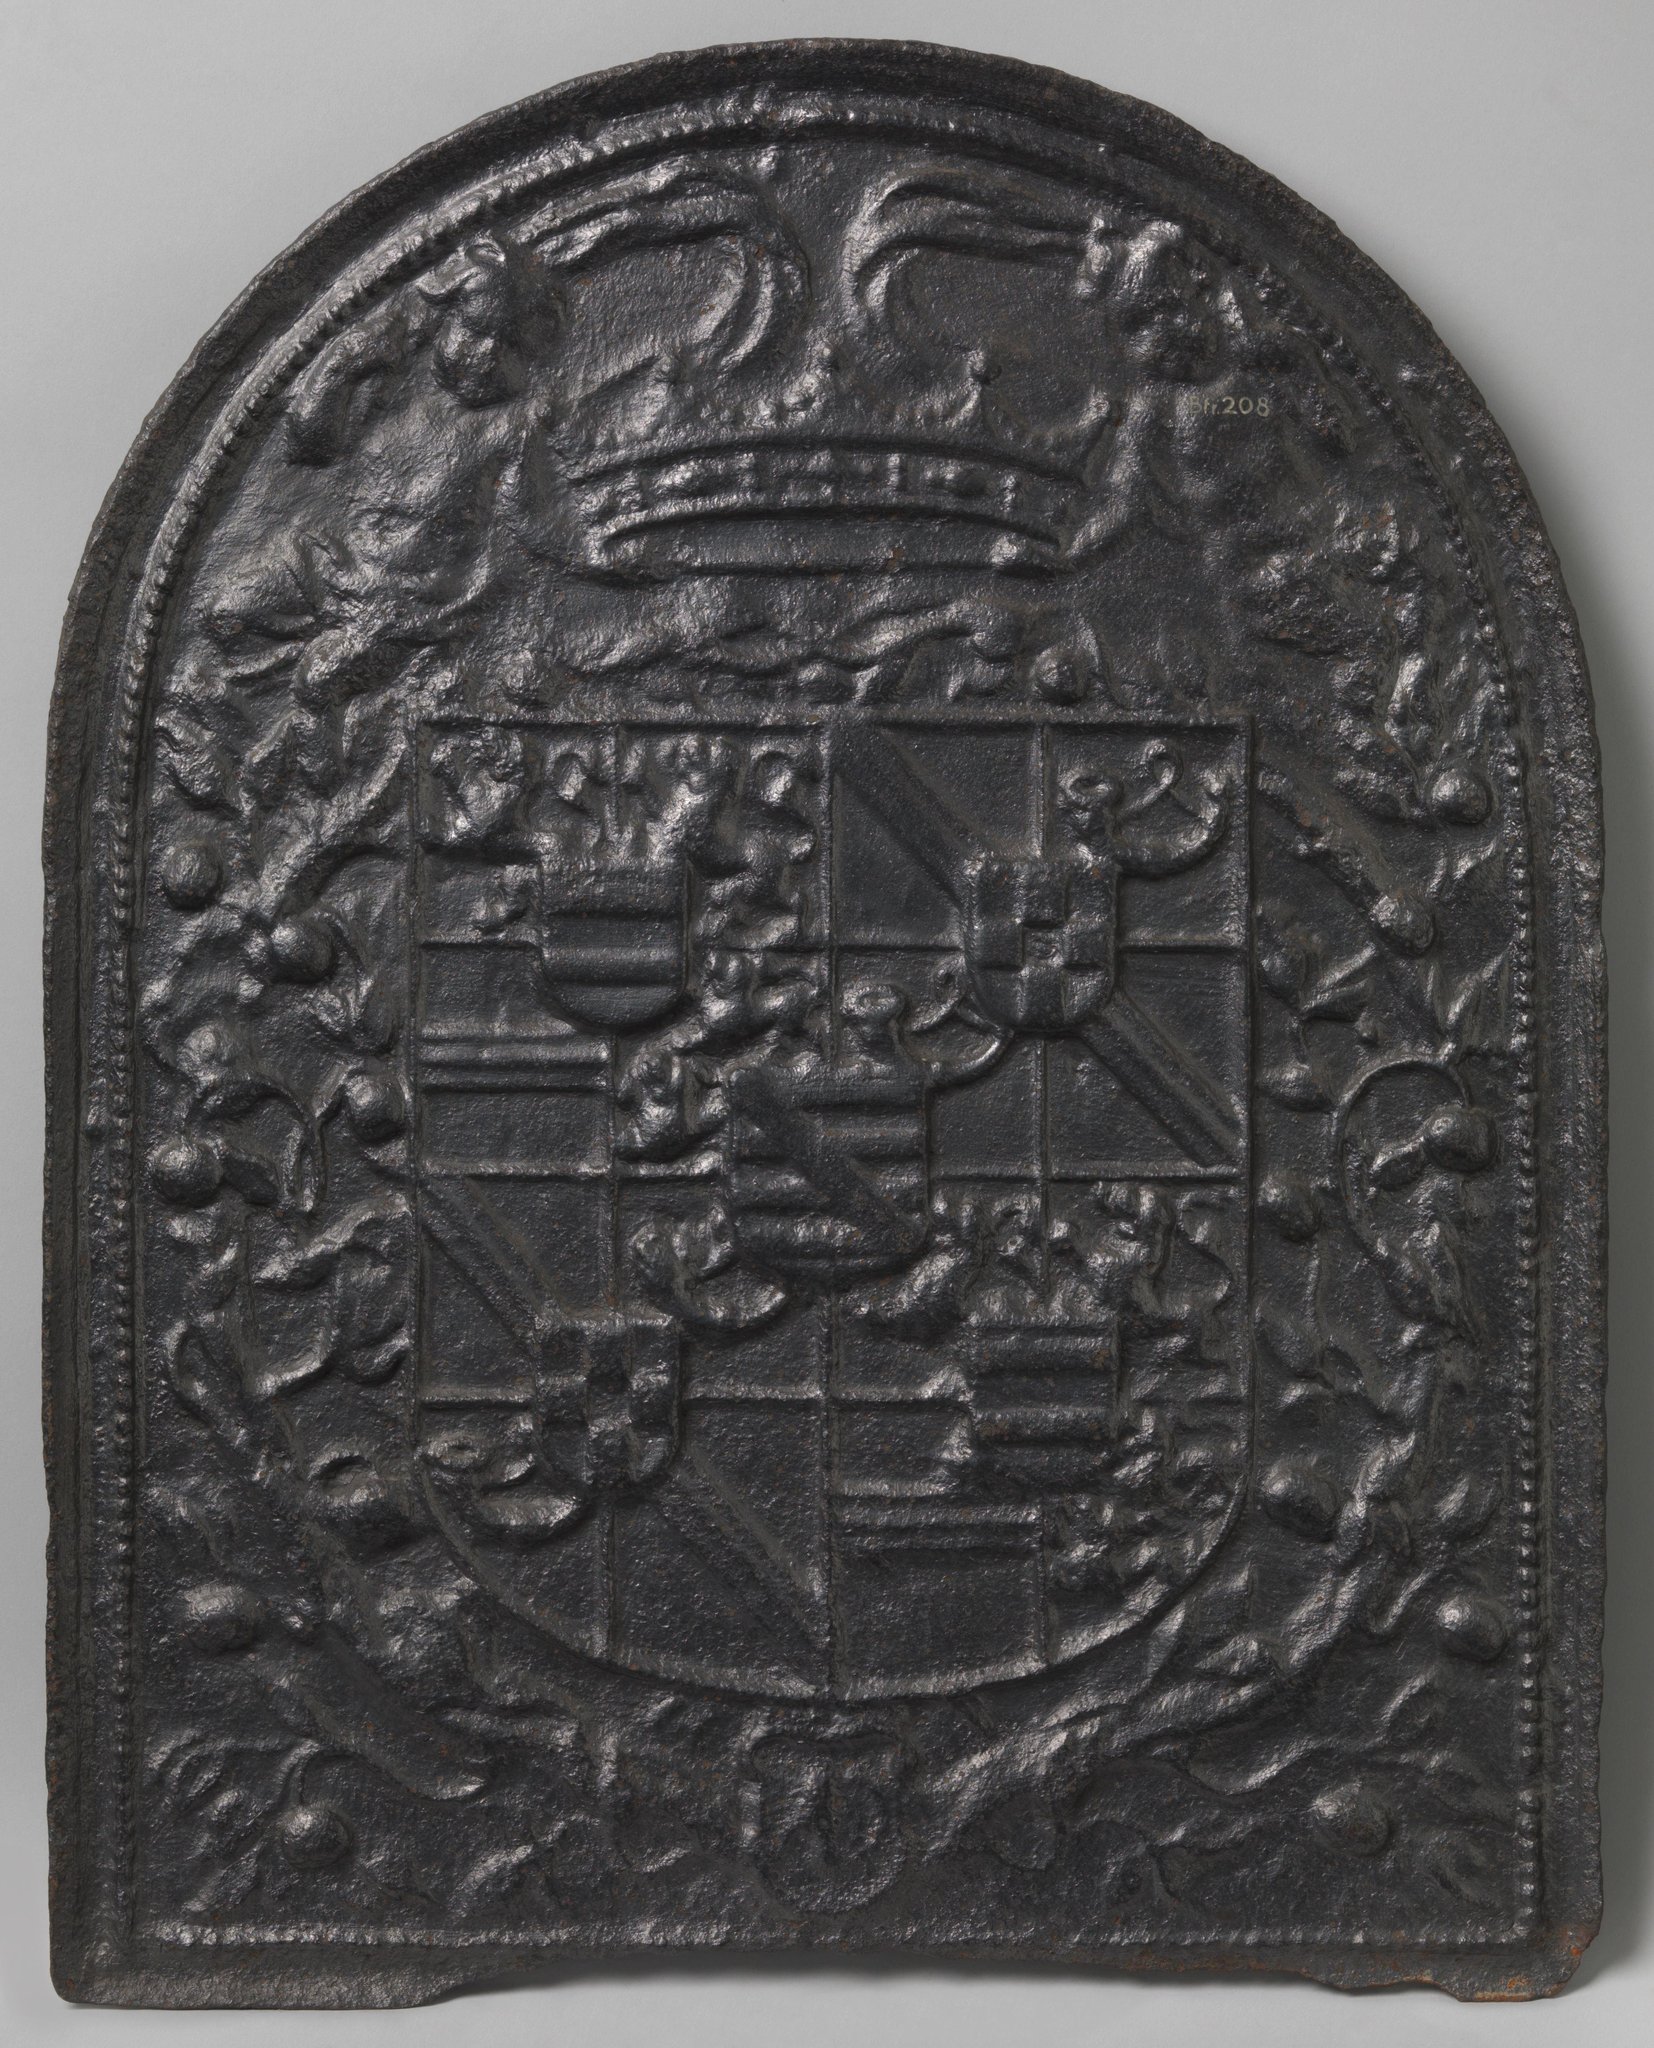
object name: fireback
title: Haardplaat met het wapen van Maurits van Oranje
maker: Anonymous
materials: iron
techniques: casting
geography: germany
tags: the hague, maurice (prince of orange)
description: Haardplaat van gietijzer, met een halfronde bovenzijde. Centraal staat het wapenschild van Maurits van Oranje. Naast de kroon vliegt aan weerszijden een putto met een band met bladranken en vruchten.